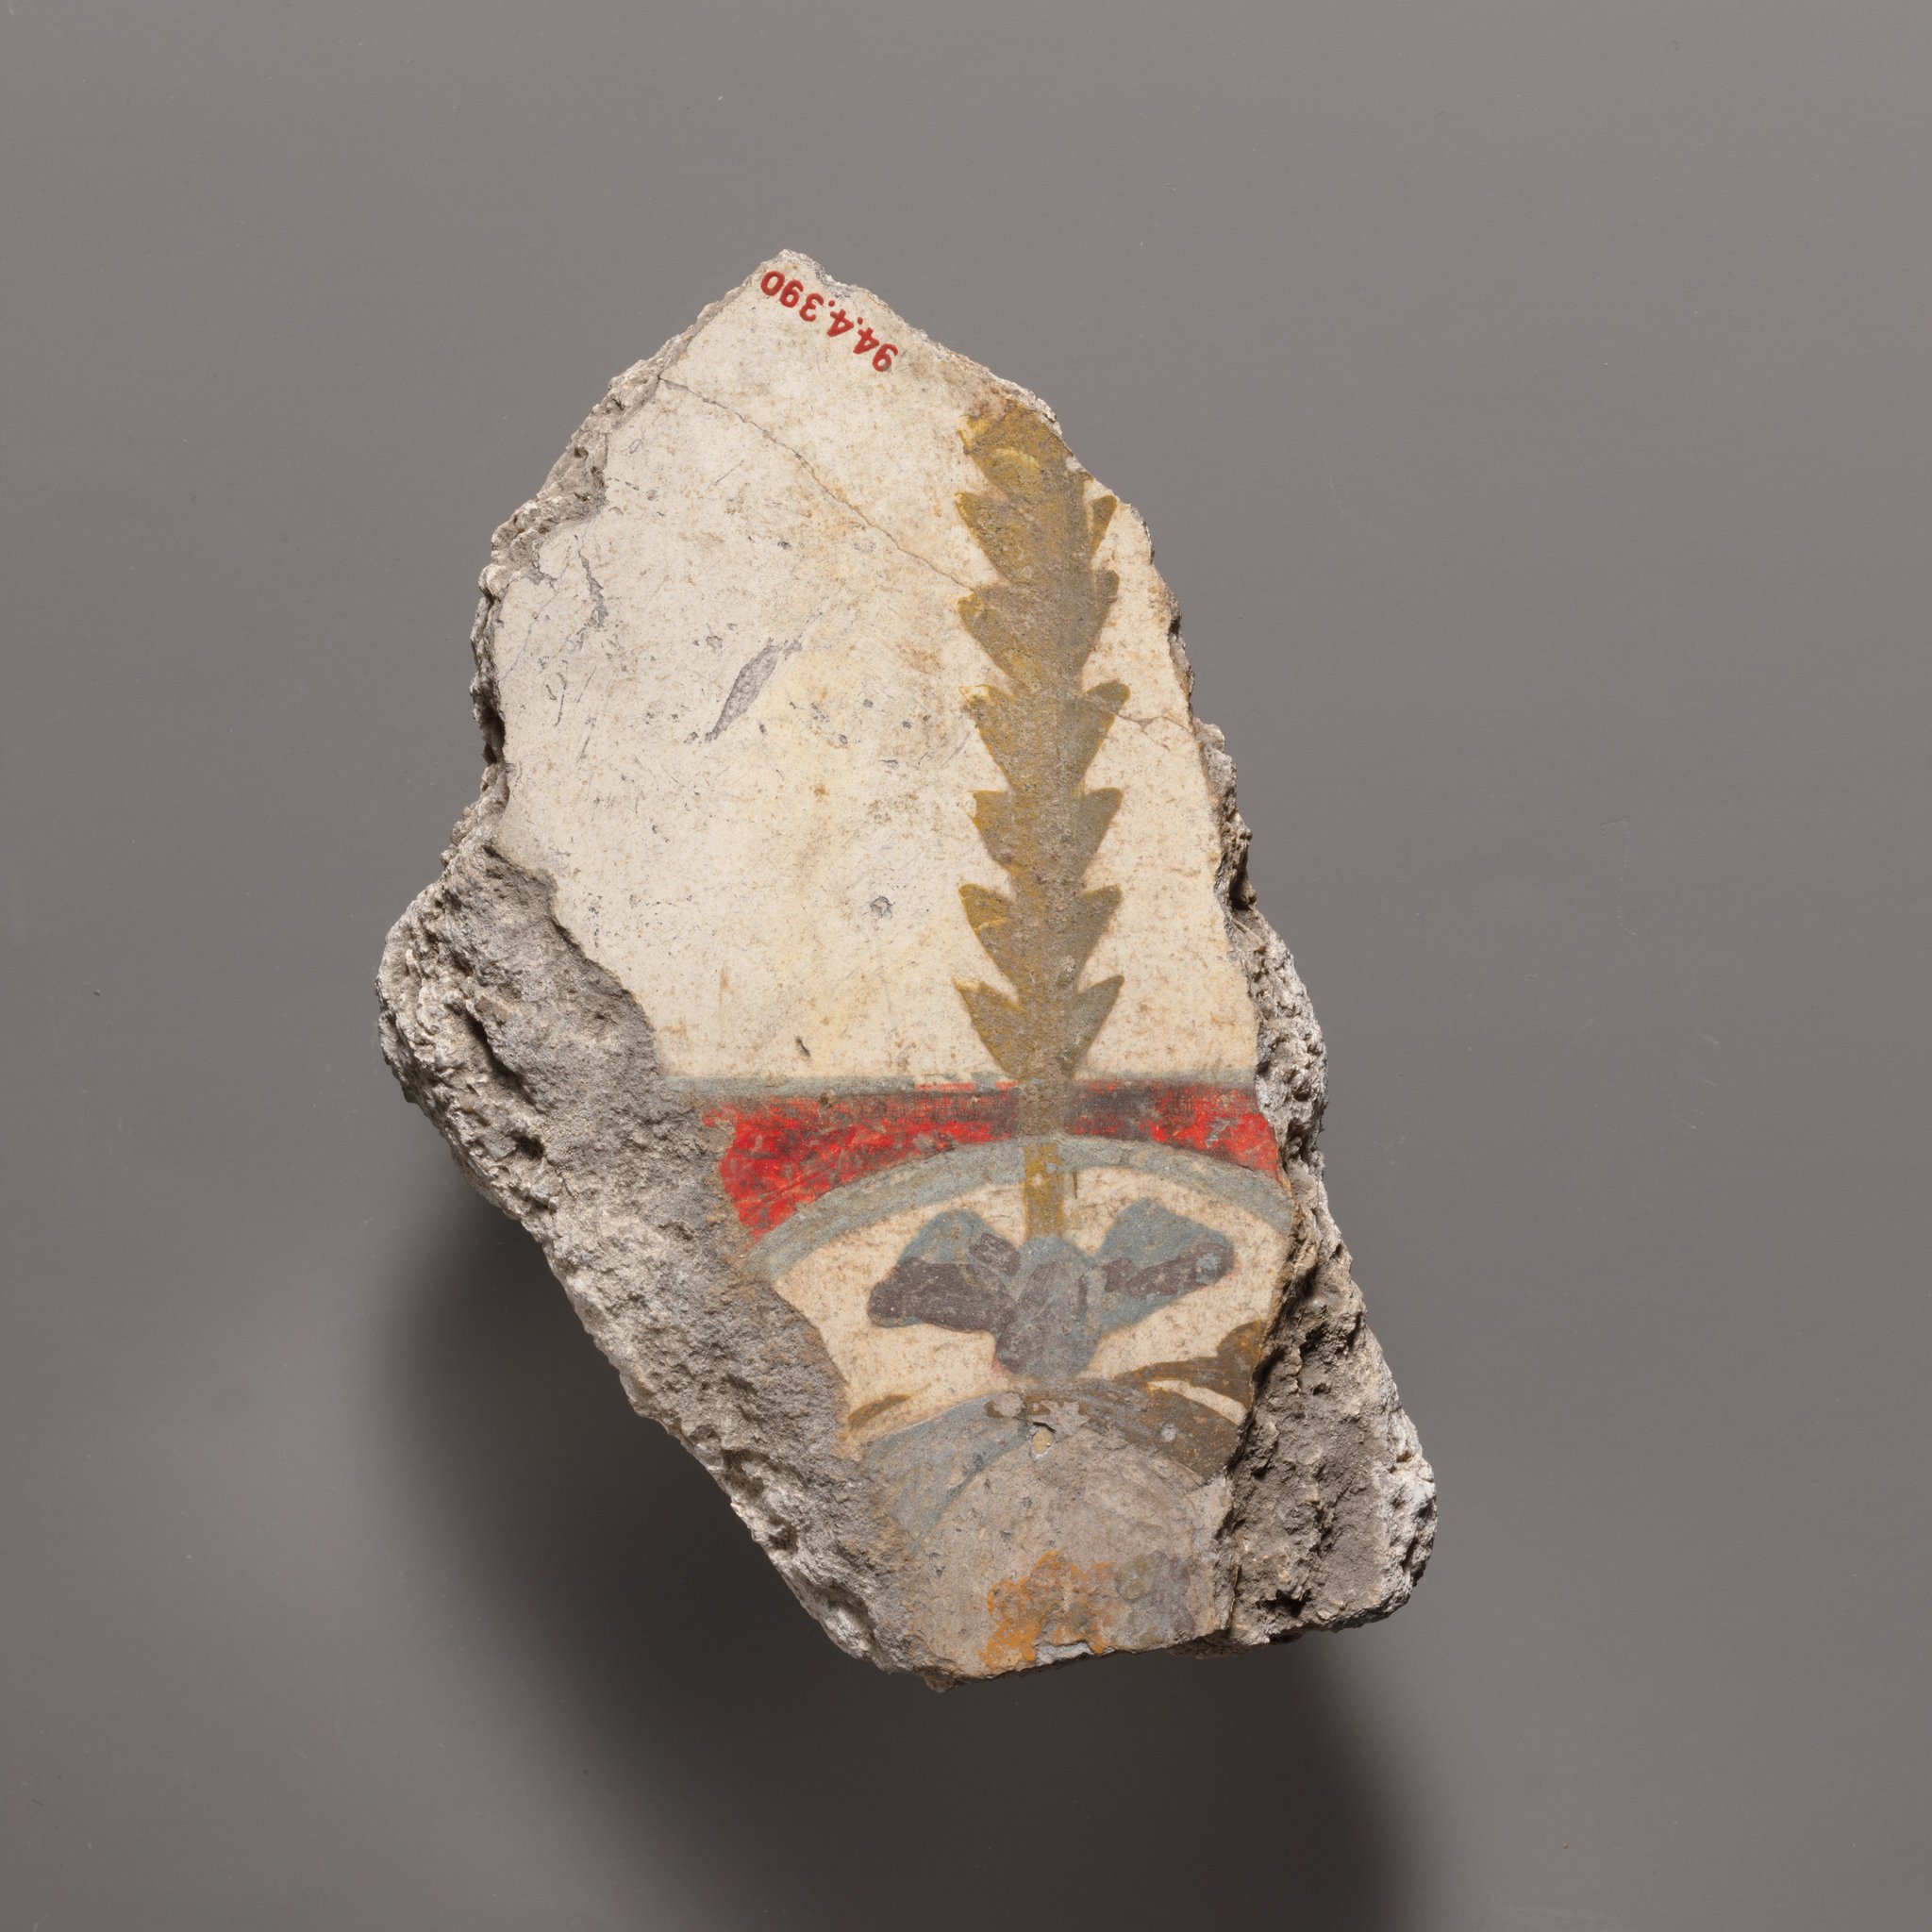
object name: wall painting fragment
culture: roman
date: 1-100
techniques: fresco